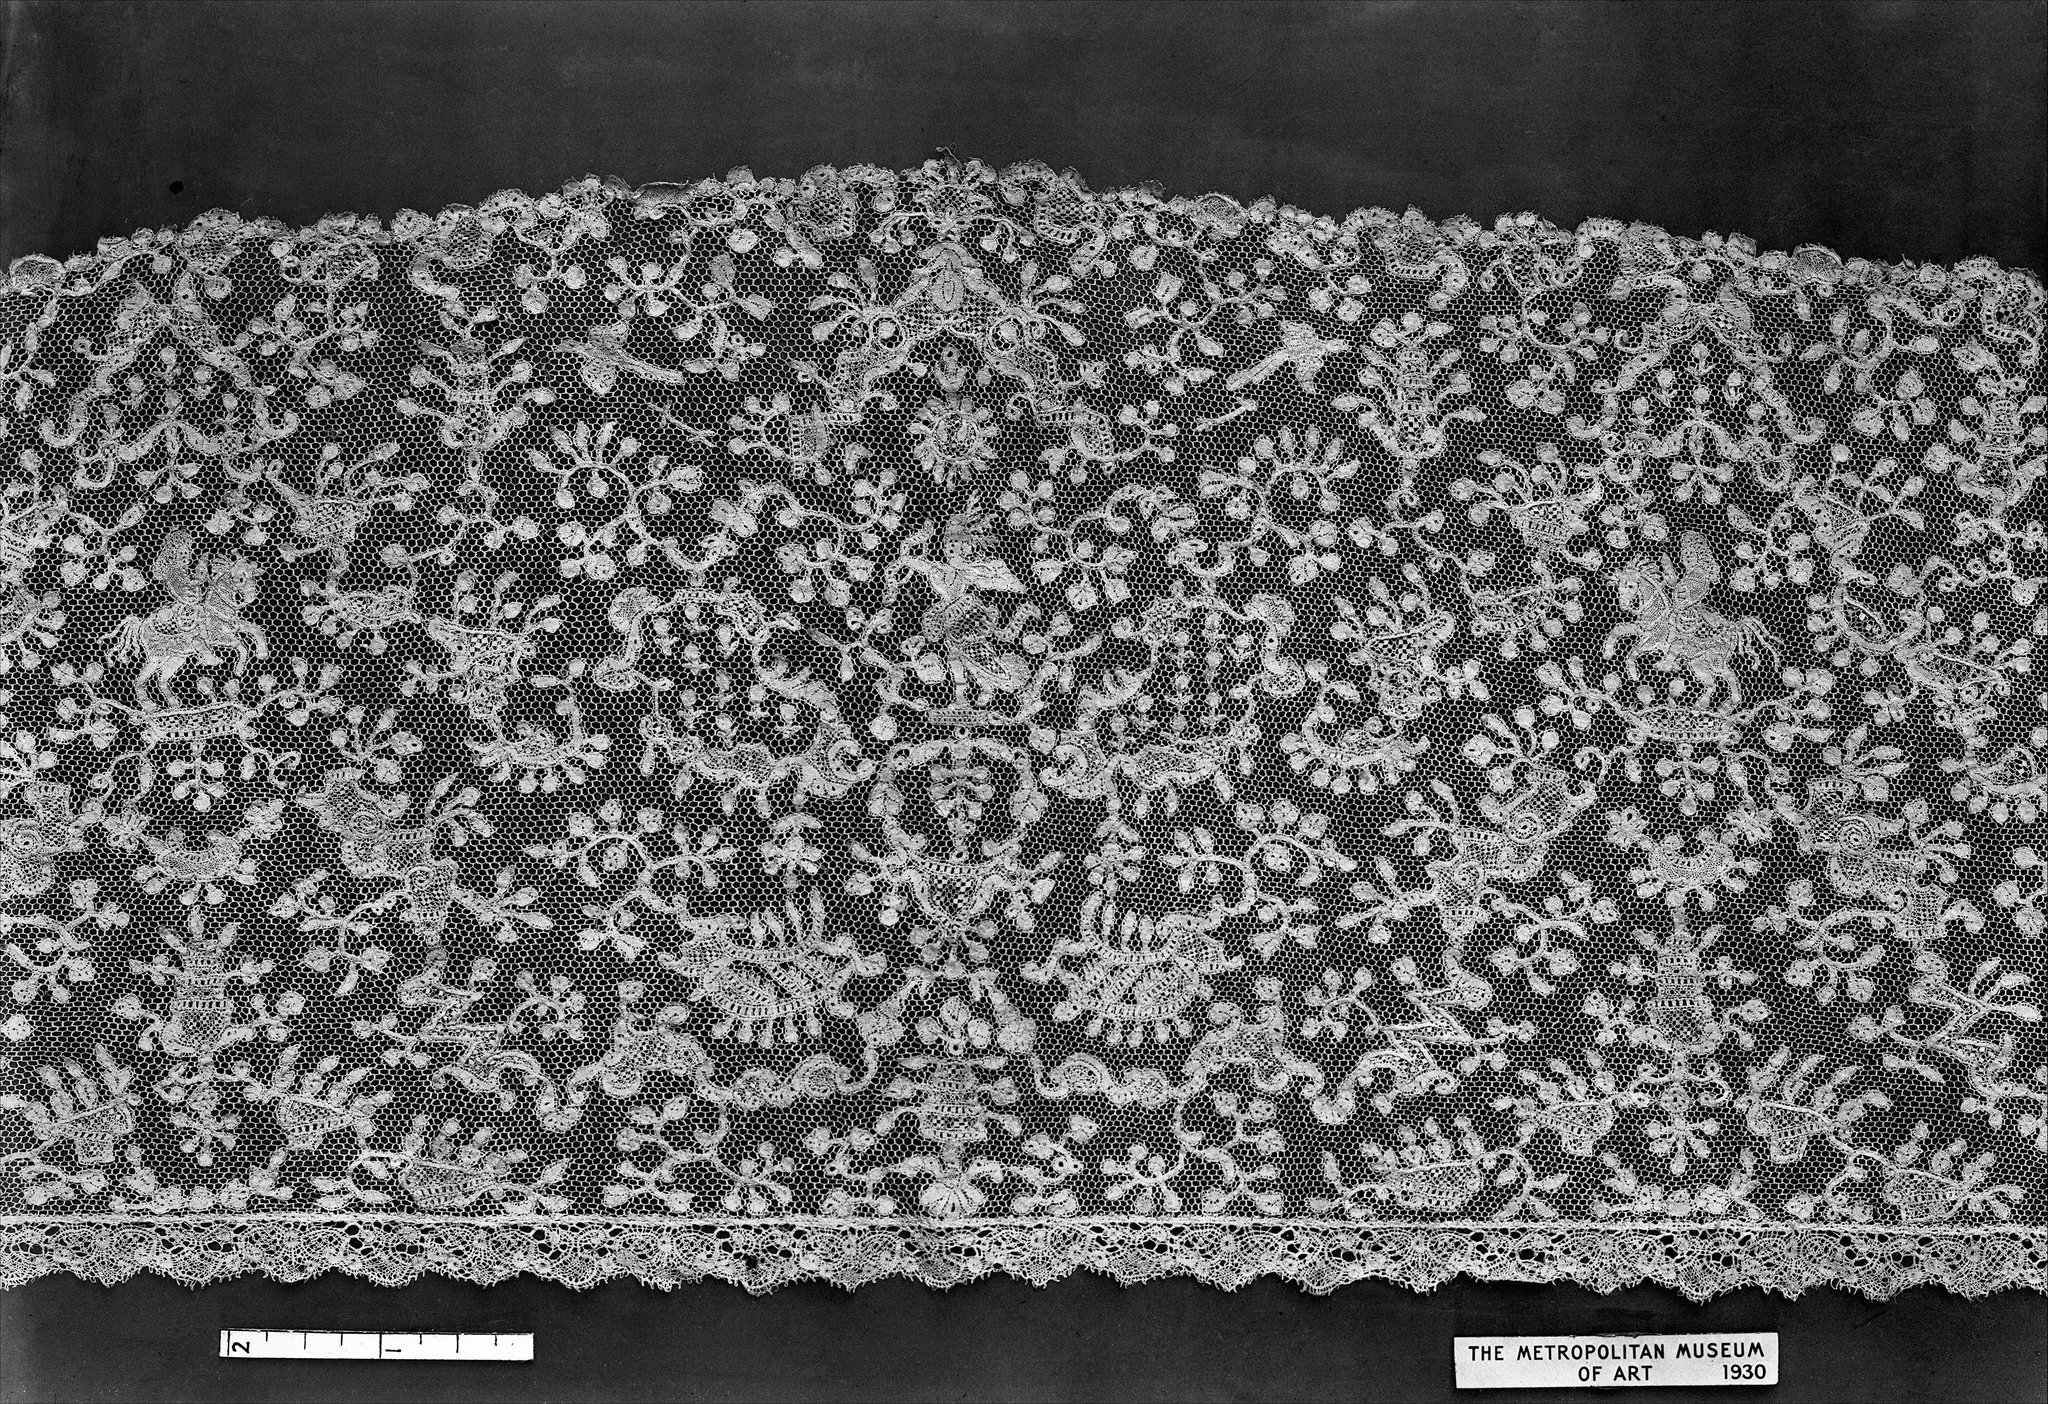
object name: headdress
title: Headdress (Fontange)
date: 1701-1733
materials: lace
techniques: lace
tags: birds,horses